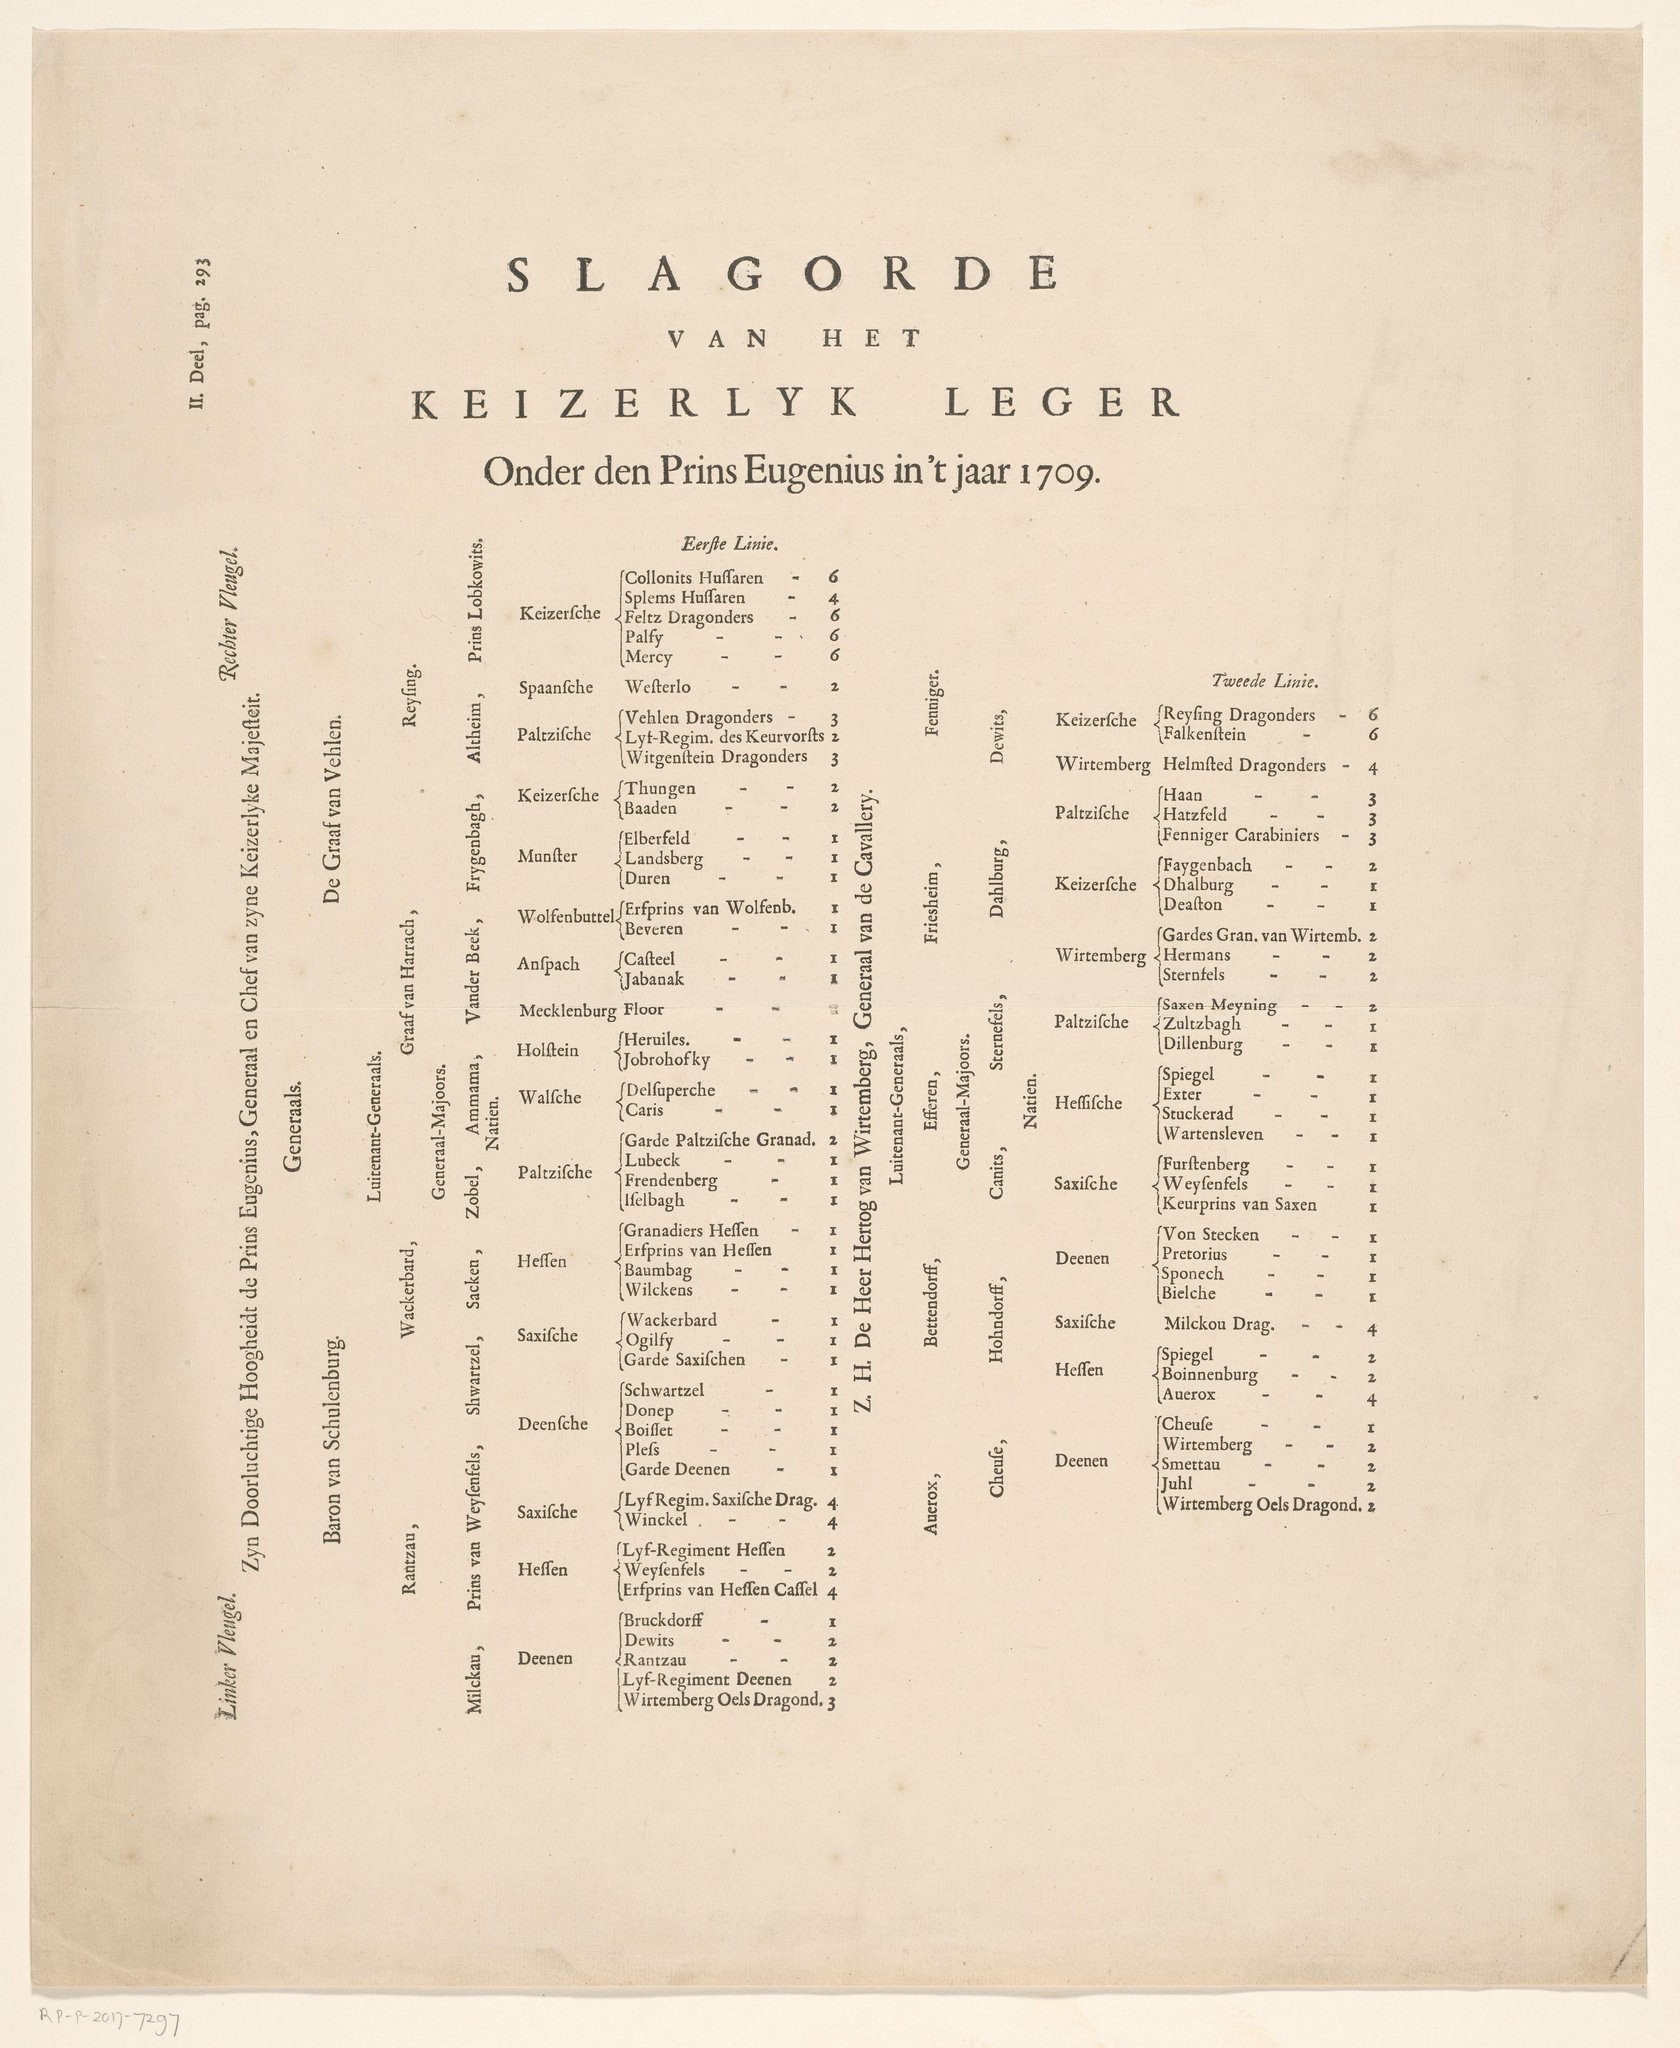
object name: text sheet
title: Slagorde van het keizerlijk leger onder den Prins Eugenius in 't jaar 1709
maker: Anonymous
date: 1709-1720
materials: paper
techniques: letterpress printing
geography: netherlands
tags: paris, vienna, eugenius van savoye, battle arrays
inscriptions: collector's mark: Lugt 2228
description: Slagorde van het keizerlijk leger onder prins Eugenius in het jaar 1709. Formatie weergegeven met de namen van de bevelhebbers van de verschillende regimenten. Linksboven gemerkt: II. Deel, pag. 293.